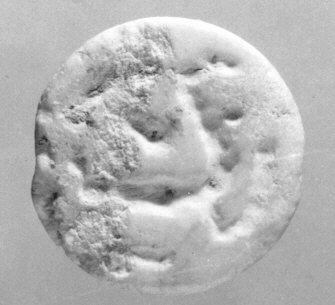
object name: stamp seal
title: Drilled oval hemispheroid seal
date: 3500-2900 BCE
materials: stone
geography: mesopotamia